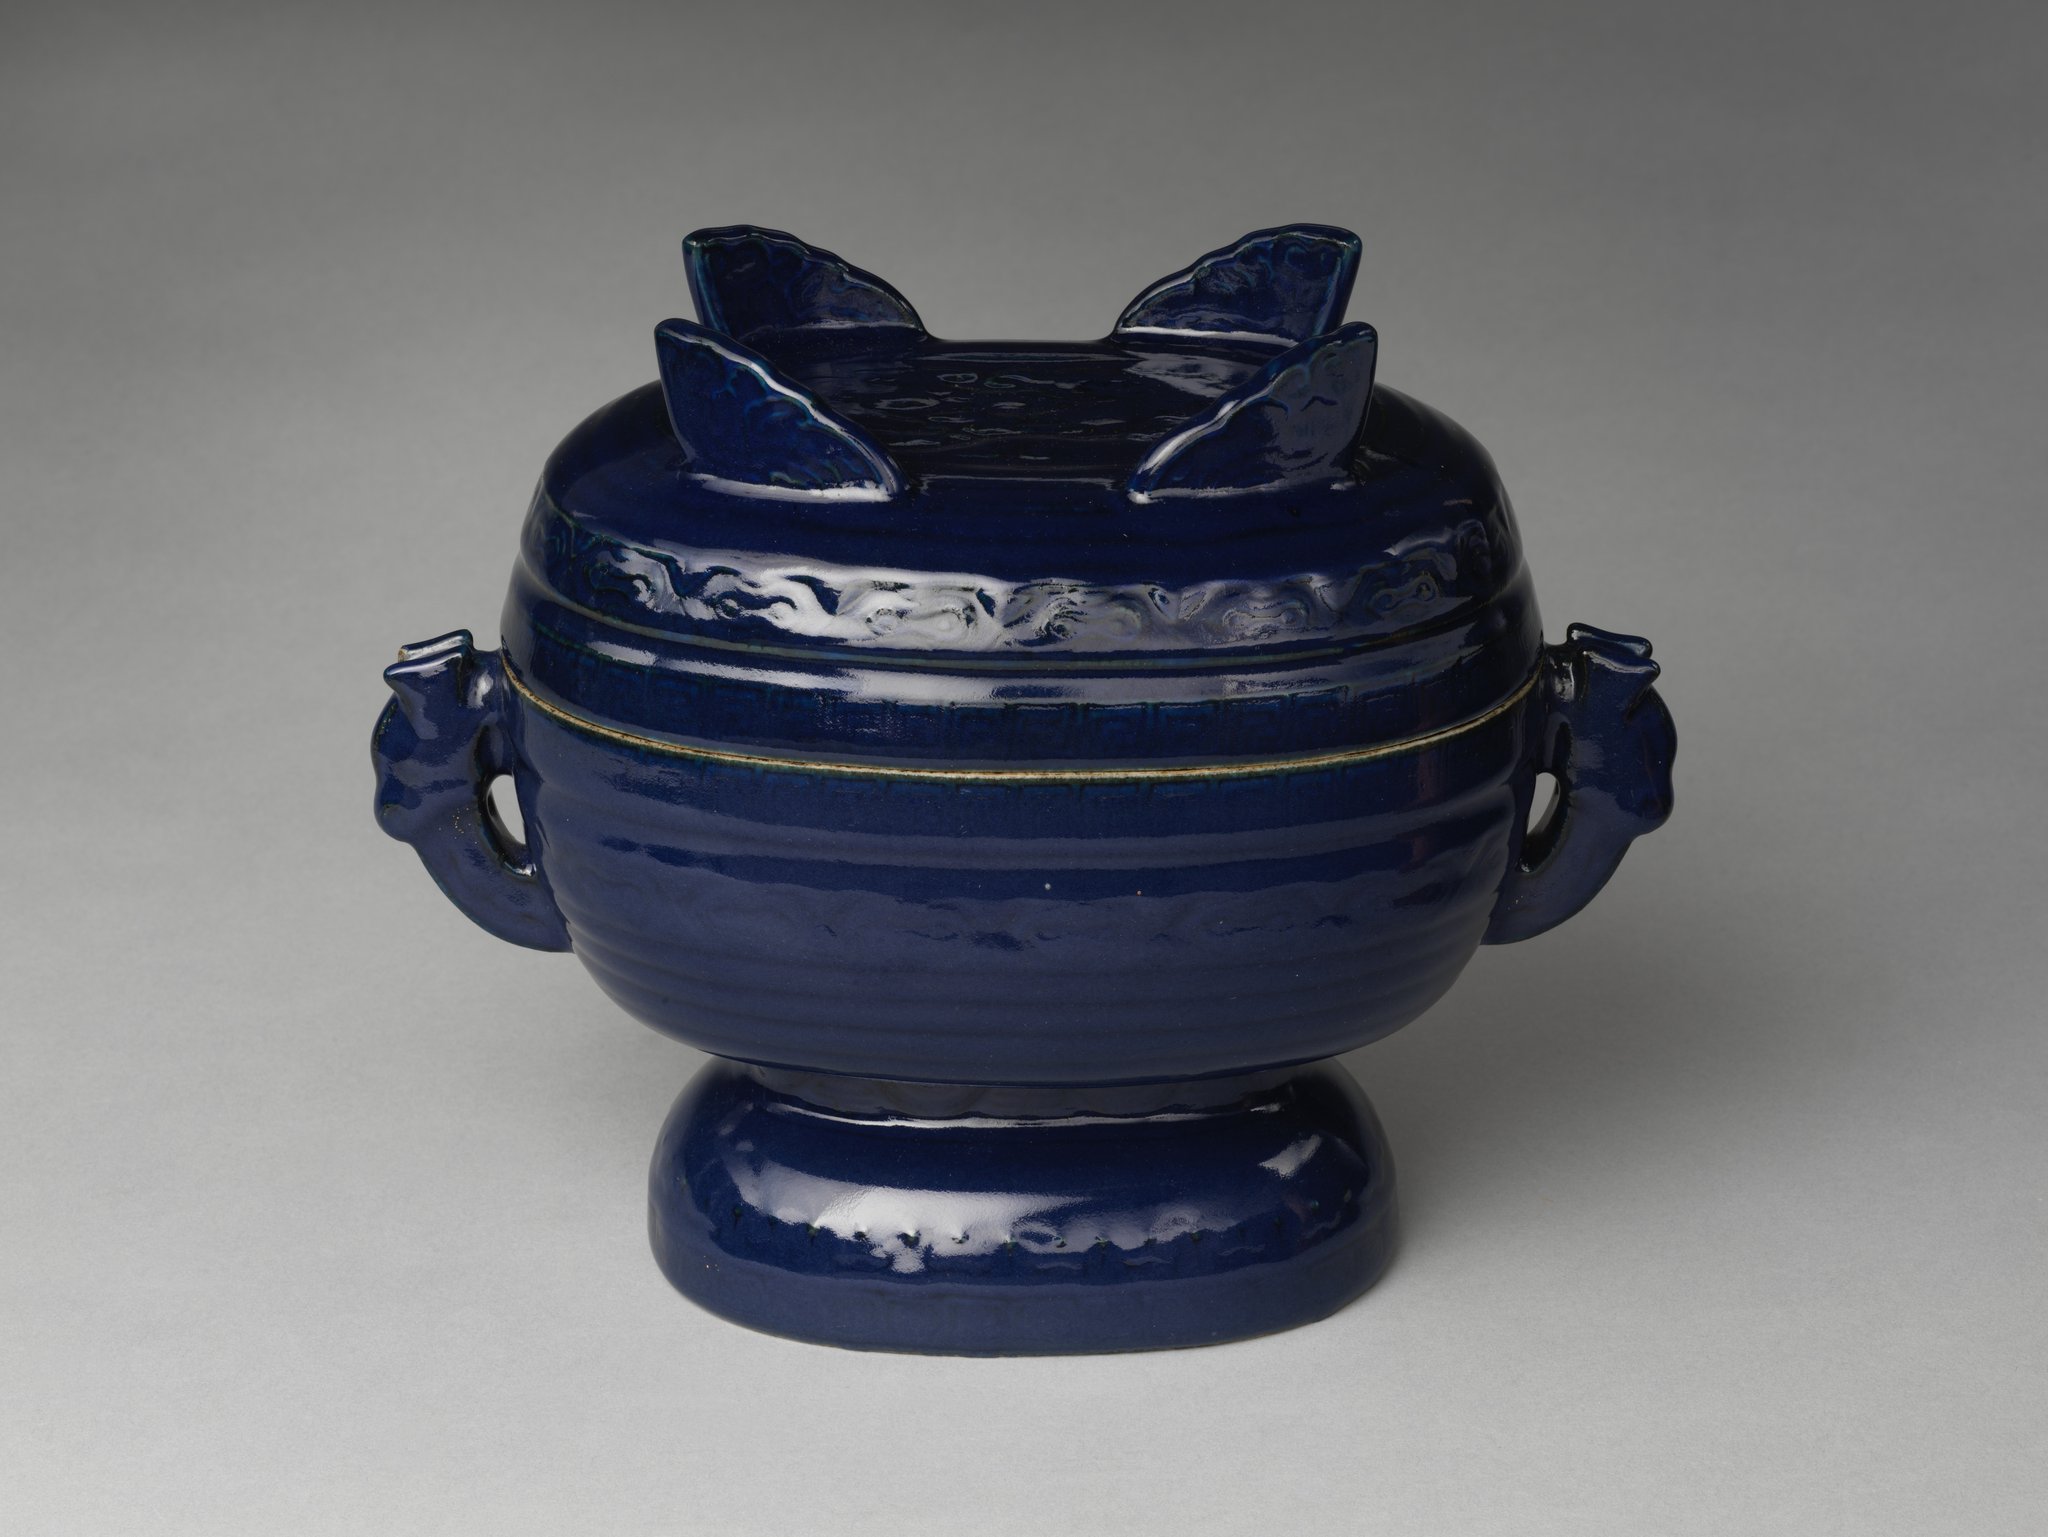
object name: vessel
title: Ritual vessel (gui)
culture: chinese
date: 1736-1795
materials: glaze, porcelain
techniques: relief